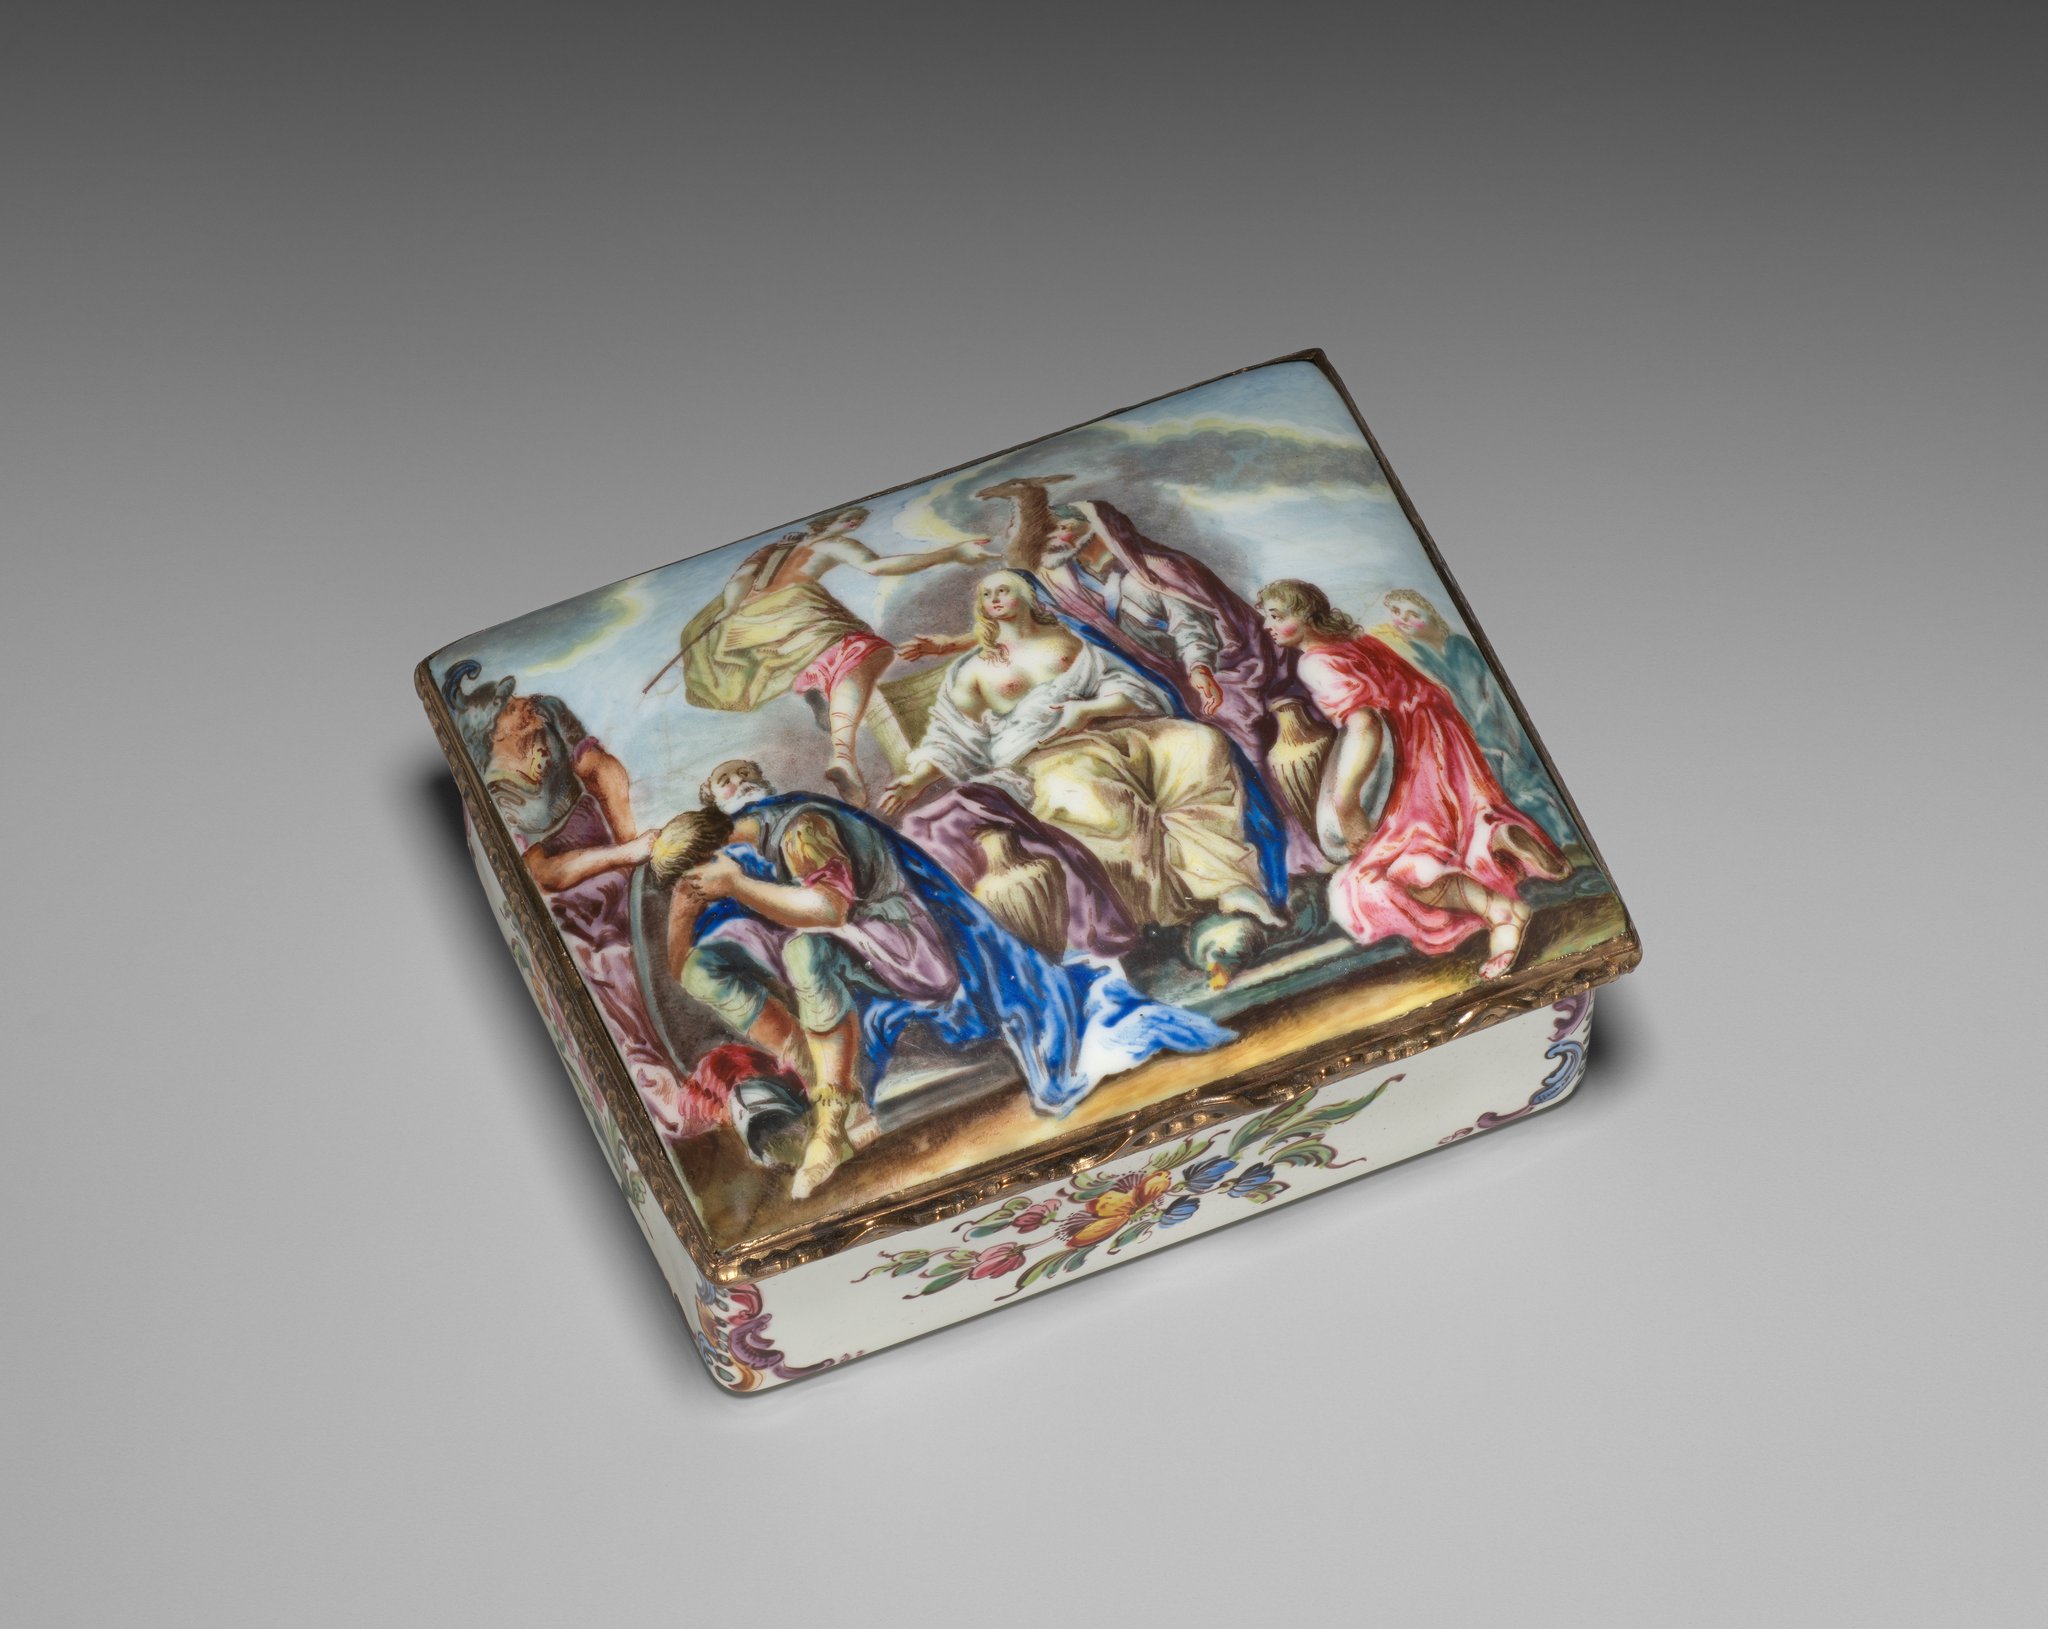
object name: snuffbox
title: The Sacrifice of Iphigenia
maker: charles de la fosse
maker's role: artist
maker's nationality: french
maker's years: 1636-1716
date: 1755-1760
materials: copper, enamel